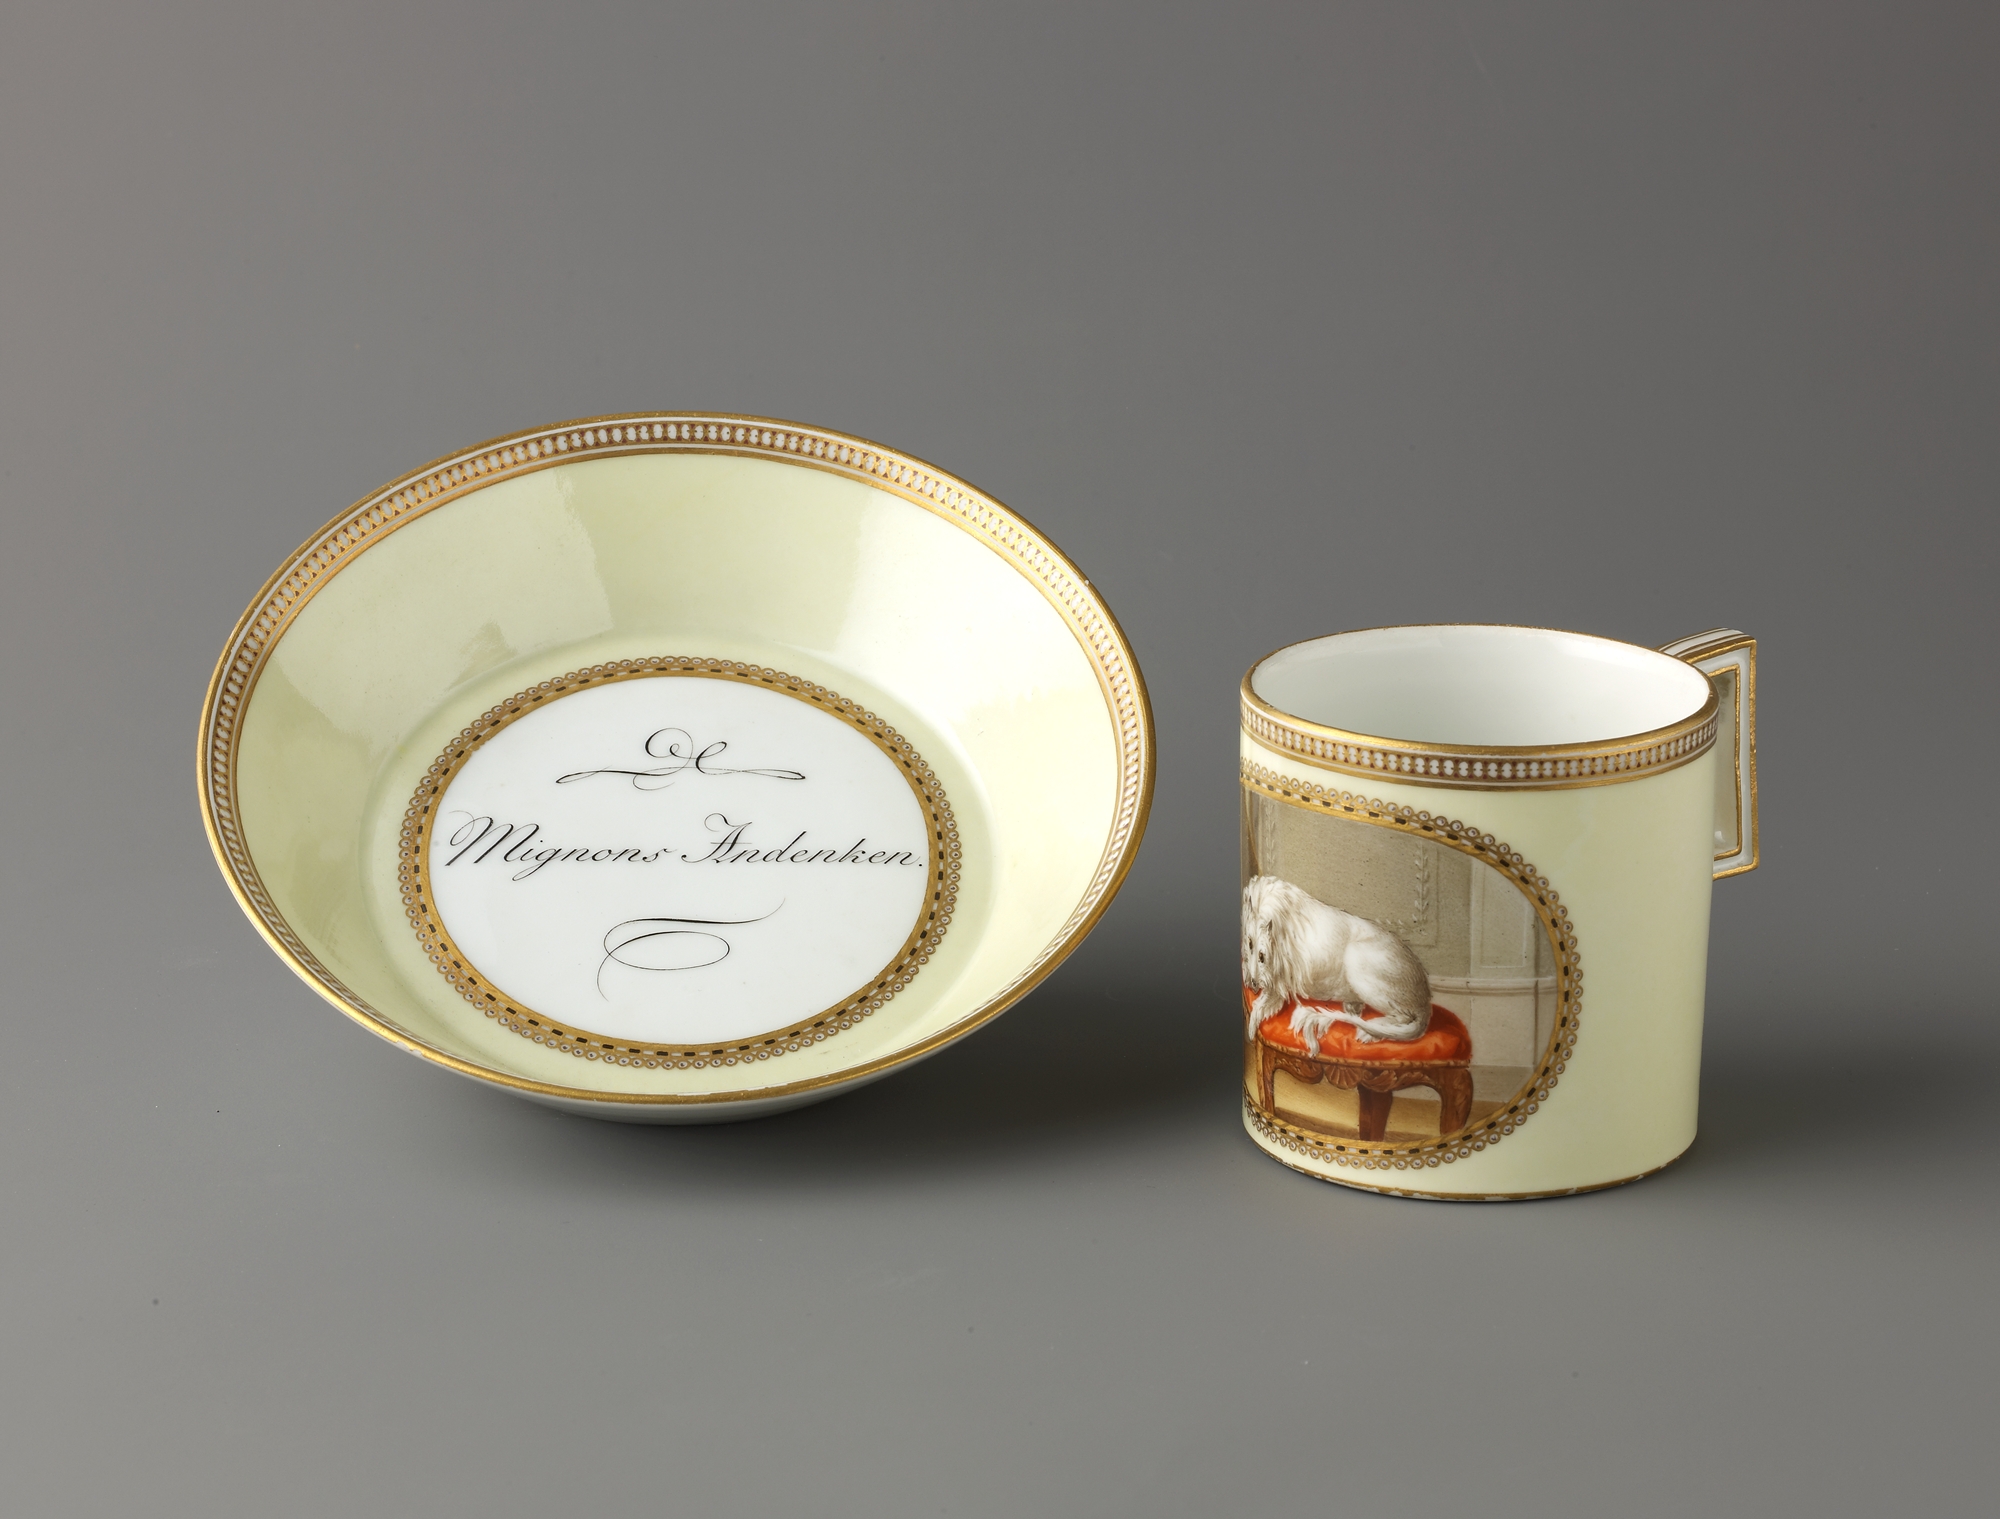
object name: cup and saucer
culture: german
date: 1775-1780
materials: hard paste porcelain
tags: dogs